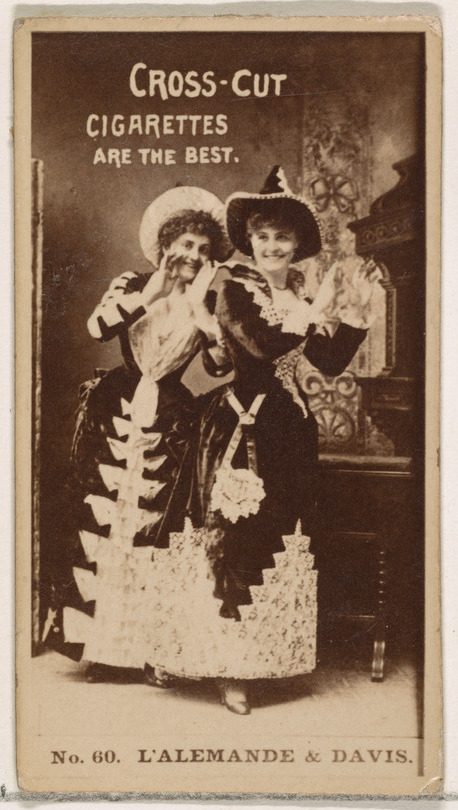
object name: print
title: Card Number 60, L'Alemande and Davis, from the Actors and Actresses series (N145-2) issued by Duke Sons & Co. to promote Cross Cut Cigarettes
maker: w. duke, sons & co.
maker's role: publisher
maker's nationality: american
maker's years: 1870-1920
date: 1880-1889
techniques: albumen silver print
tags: portraits,women,actresses